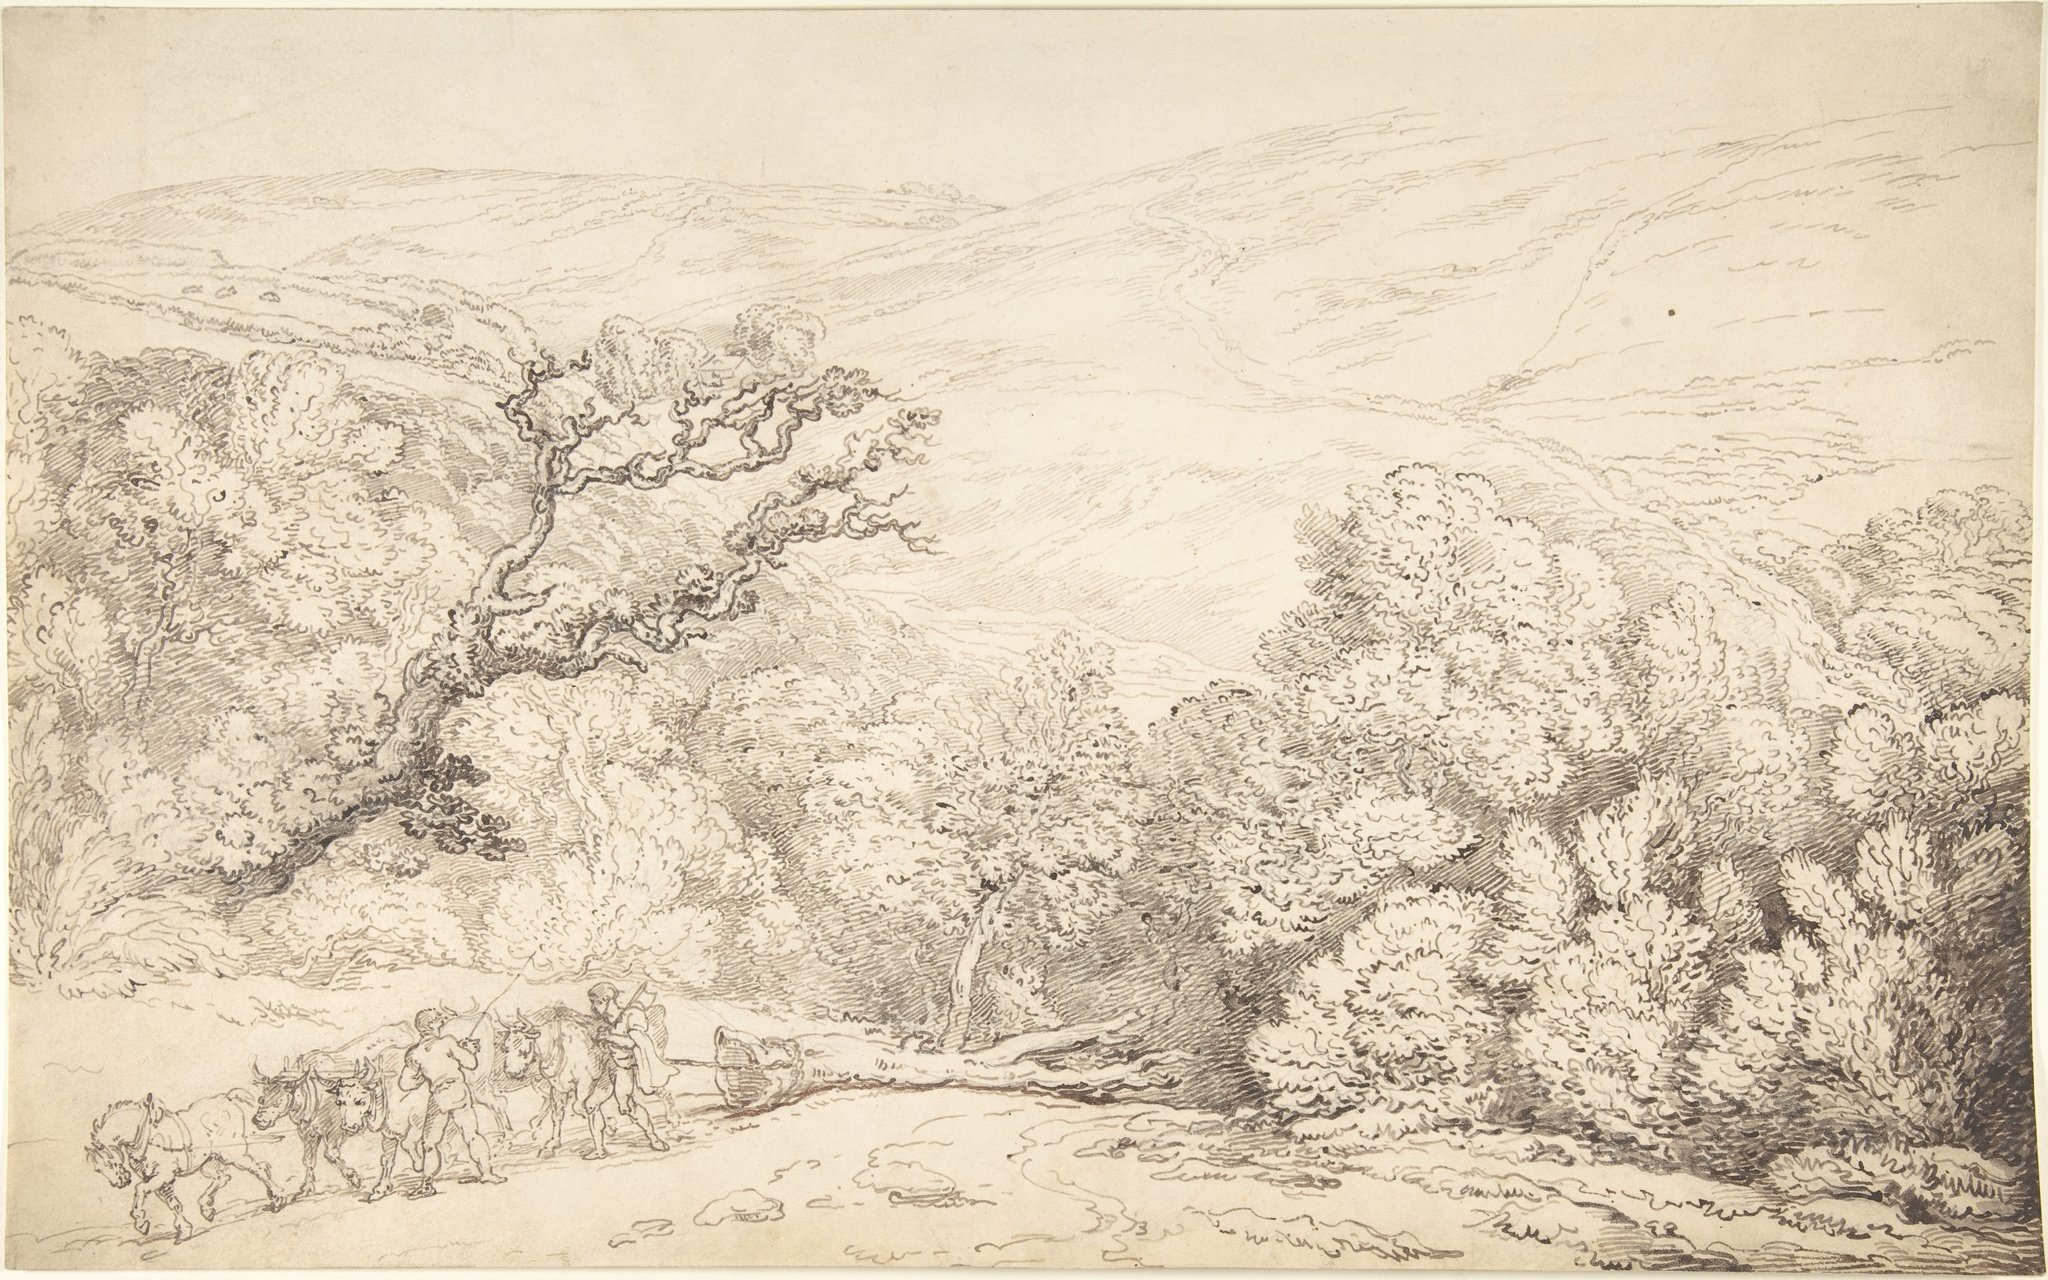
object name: drawing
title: Landscape with Oxen and Felled Tree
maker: thomas rowlandson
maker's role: artist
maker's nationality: british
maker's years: 1757-1827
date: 1775-1827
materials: graphite, ink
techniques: pen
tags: animals,landscapes,trees